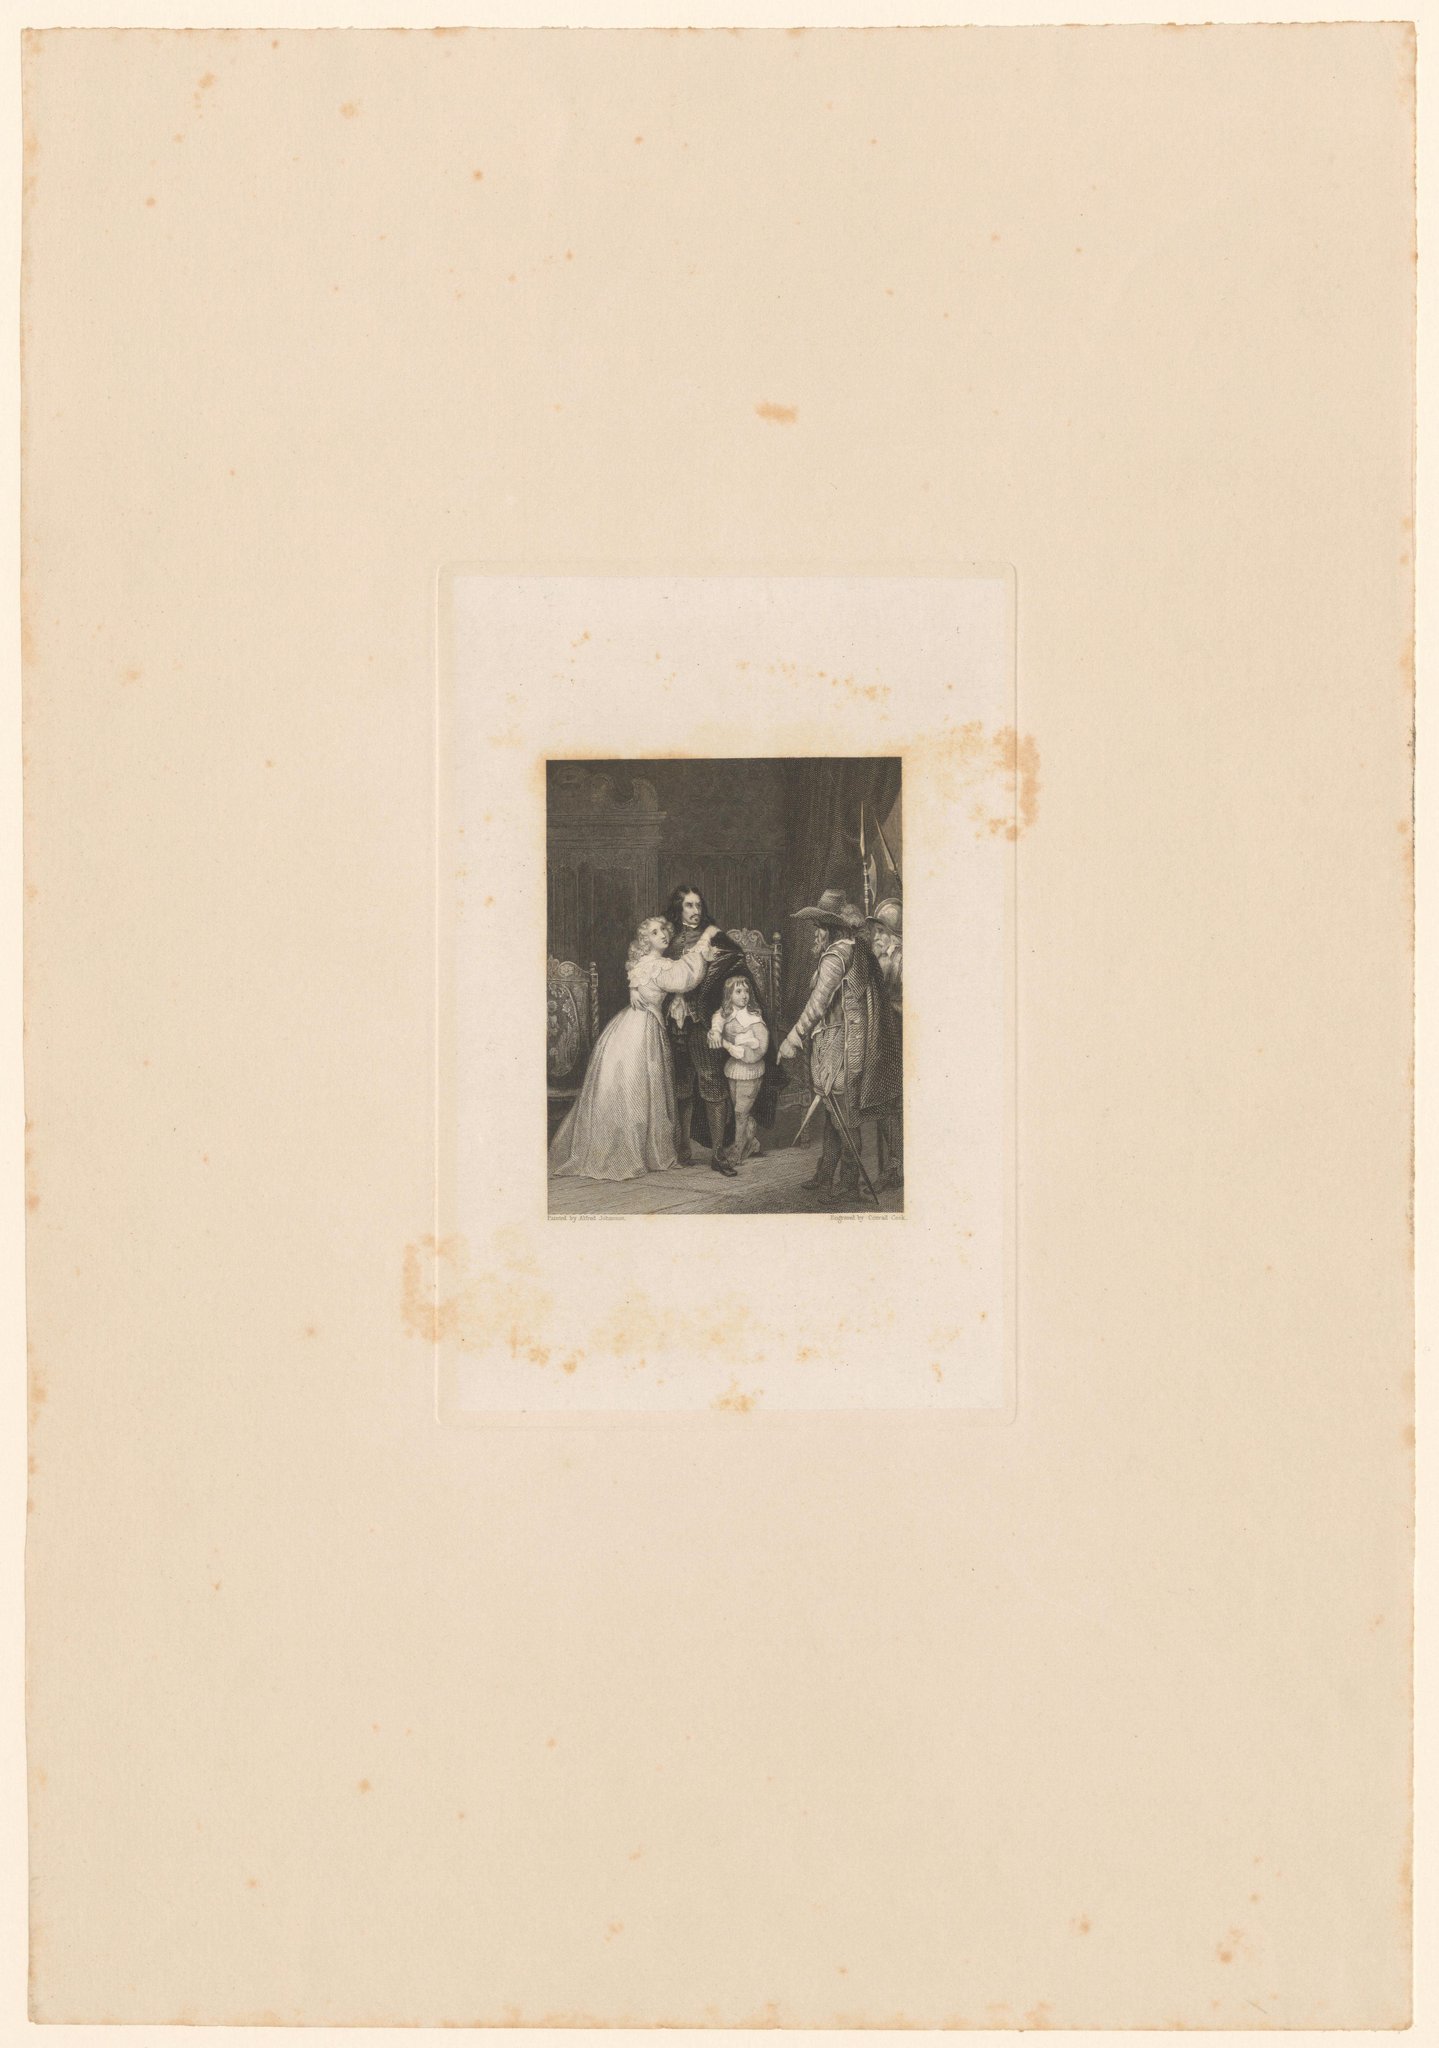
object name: print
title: Man wordt door soldaten gesommeerd mee te komen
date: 1810-1850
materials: paper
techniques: engraving, etching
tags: arrest (of criminal)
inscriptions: collector's mark: Lugt 2228